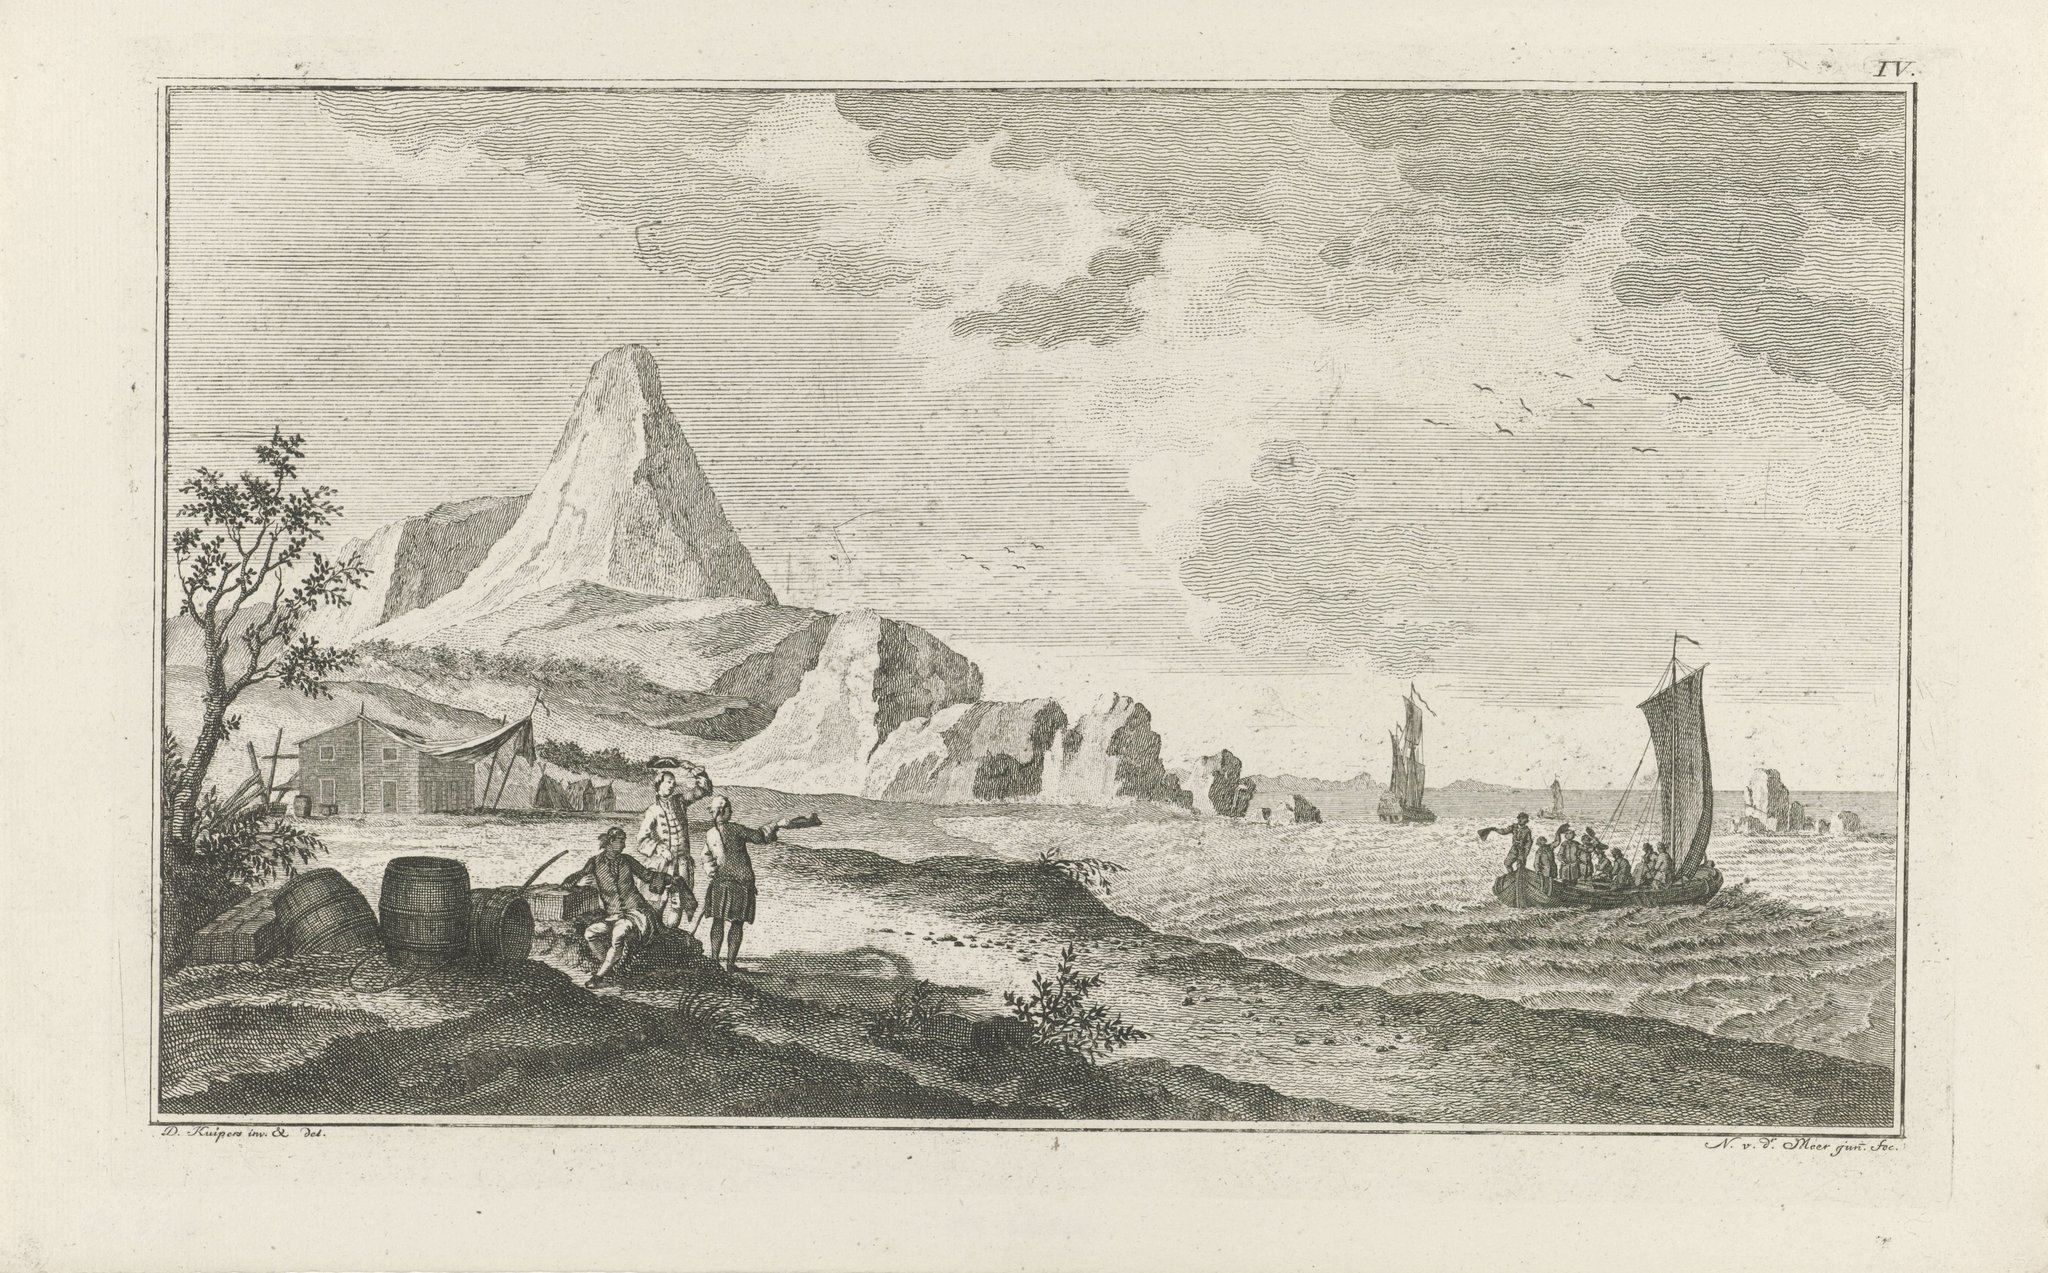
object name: print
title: Vertrekkende schepen voor de kust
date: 1766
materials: paper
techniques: etching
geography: leiden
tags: ships (in general), waving farewell ~ departure on a journey, beach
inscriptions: collector's mark: Lugt 2228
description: Prent uit: Anson Lord, George. Reize naer de Zuidzee, met het schip de Wager, onder het opzicht van den heere George Anson. Ondernomen in den jaere 1740. Amsterdam en Leiden: Steven Jacobus Baalde, Cornelis van Hoogeveen junior, Johannes Le Mair, 1766.